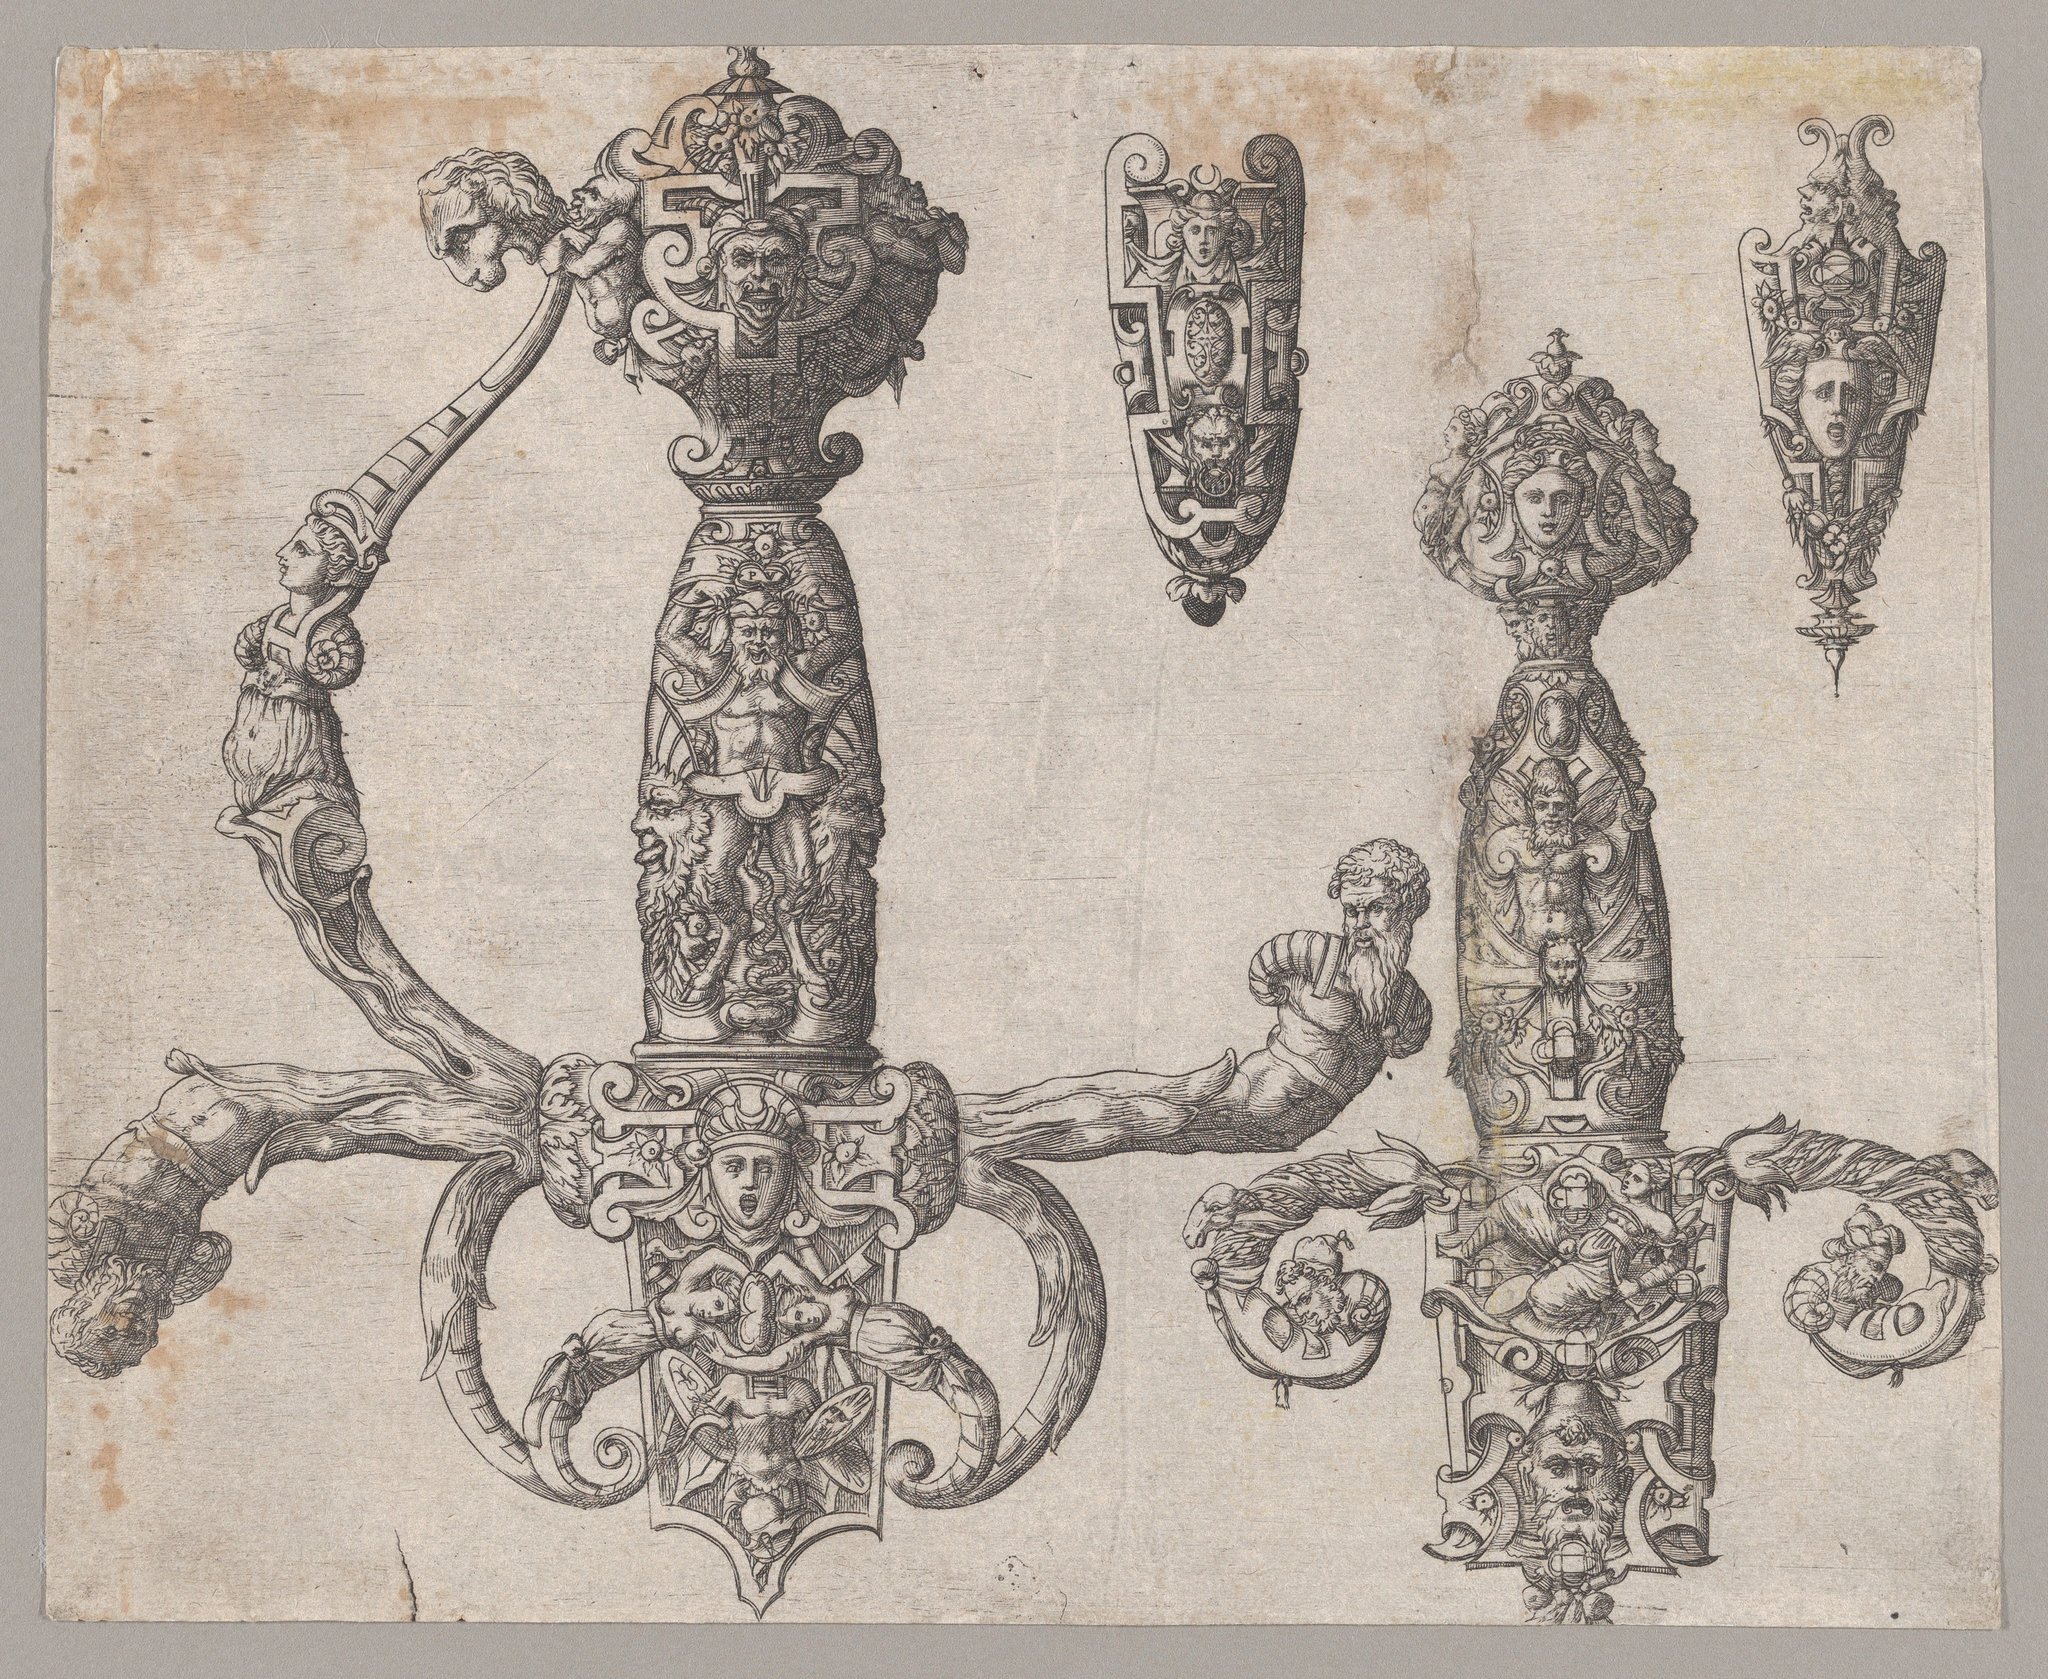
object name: print ornament architecture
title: Sheet with Four Designs for Relief Decorations on Arms: Two Large Hilts for a Sword and a Dagger, and the Ornaments for the Tips of the Sheaths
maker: pierre woeiriot de bouzey ii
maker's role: artist and engraver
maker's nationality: french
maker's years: 1532-1599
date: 1550-1560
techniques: engraving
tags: hilts,female nudes,satyrs